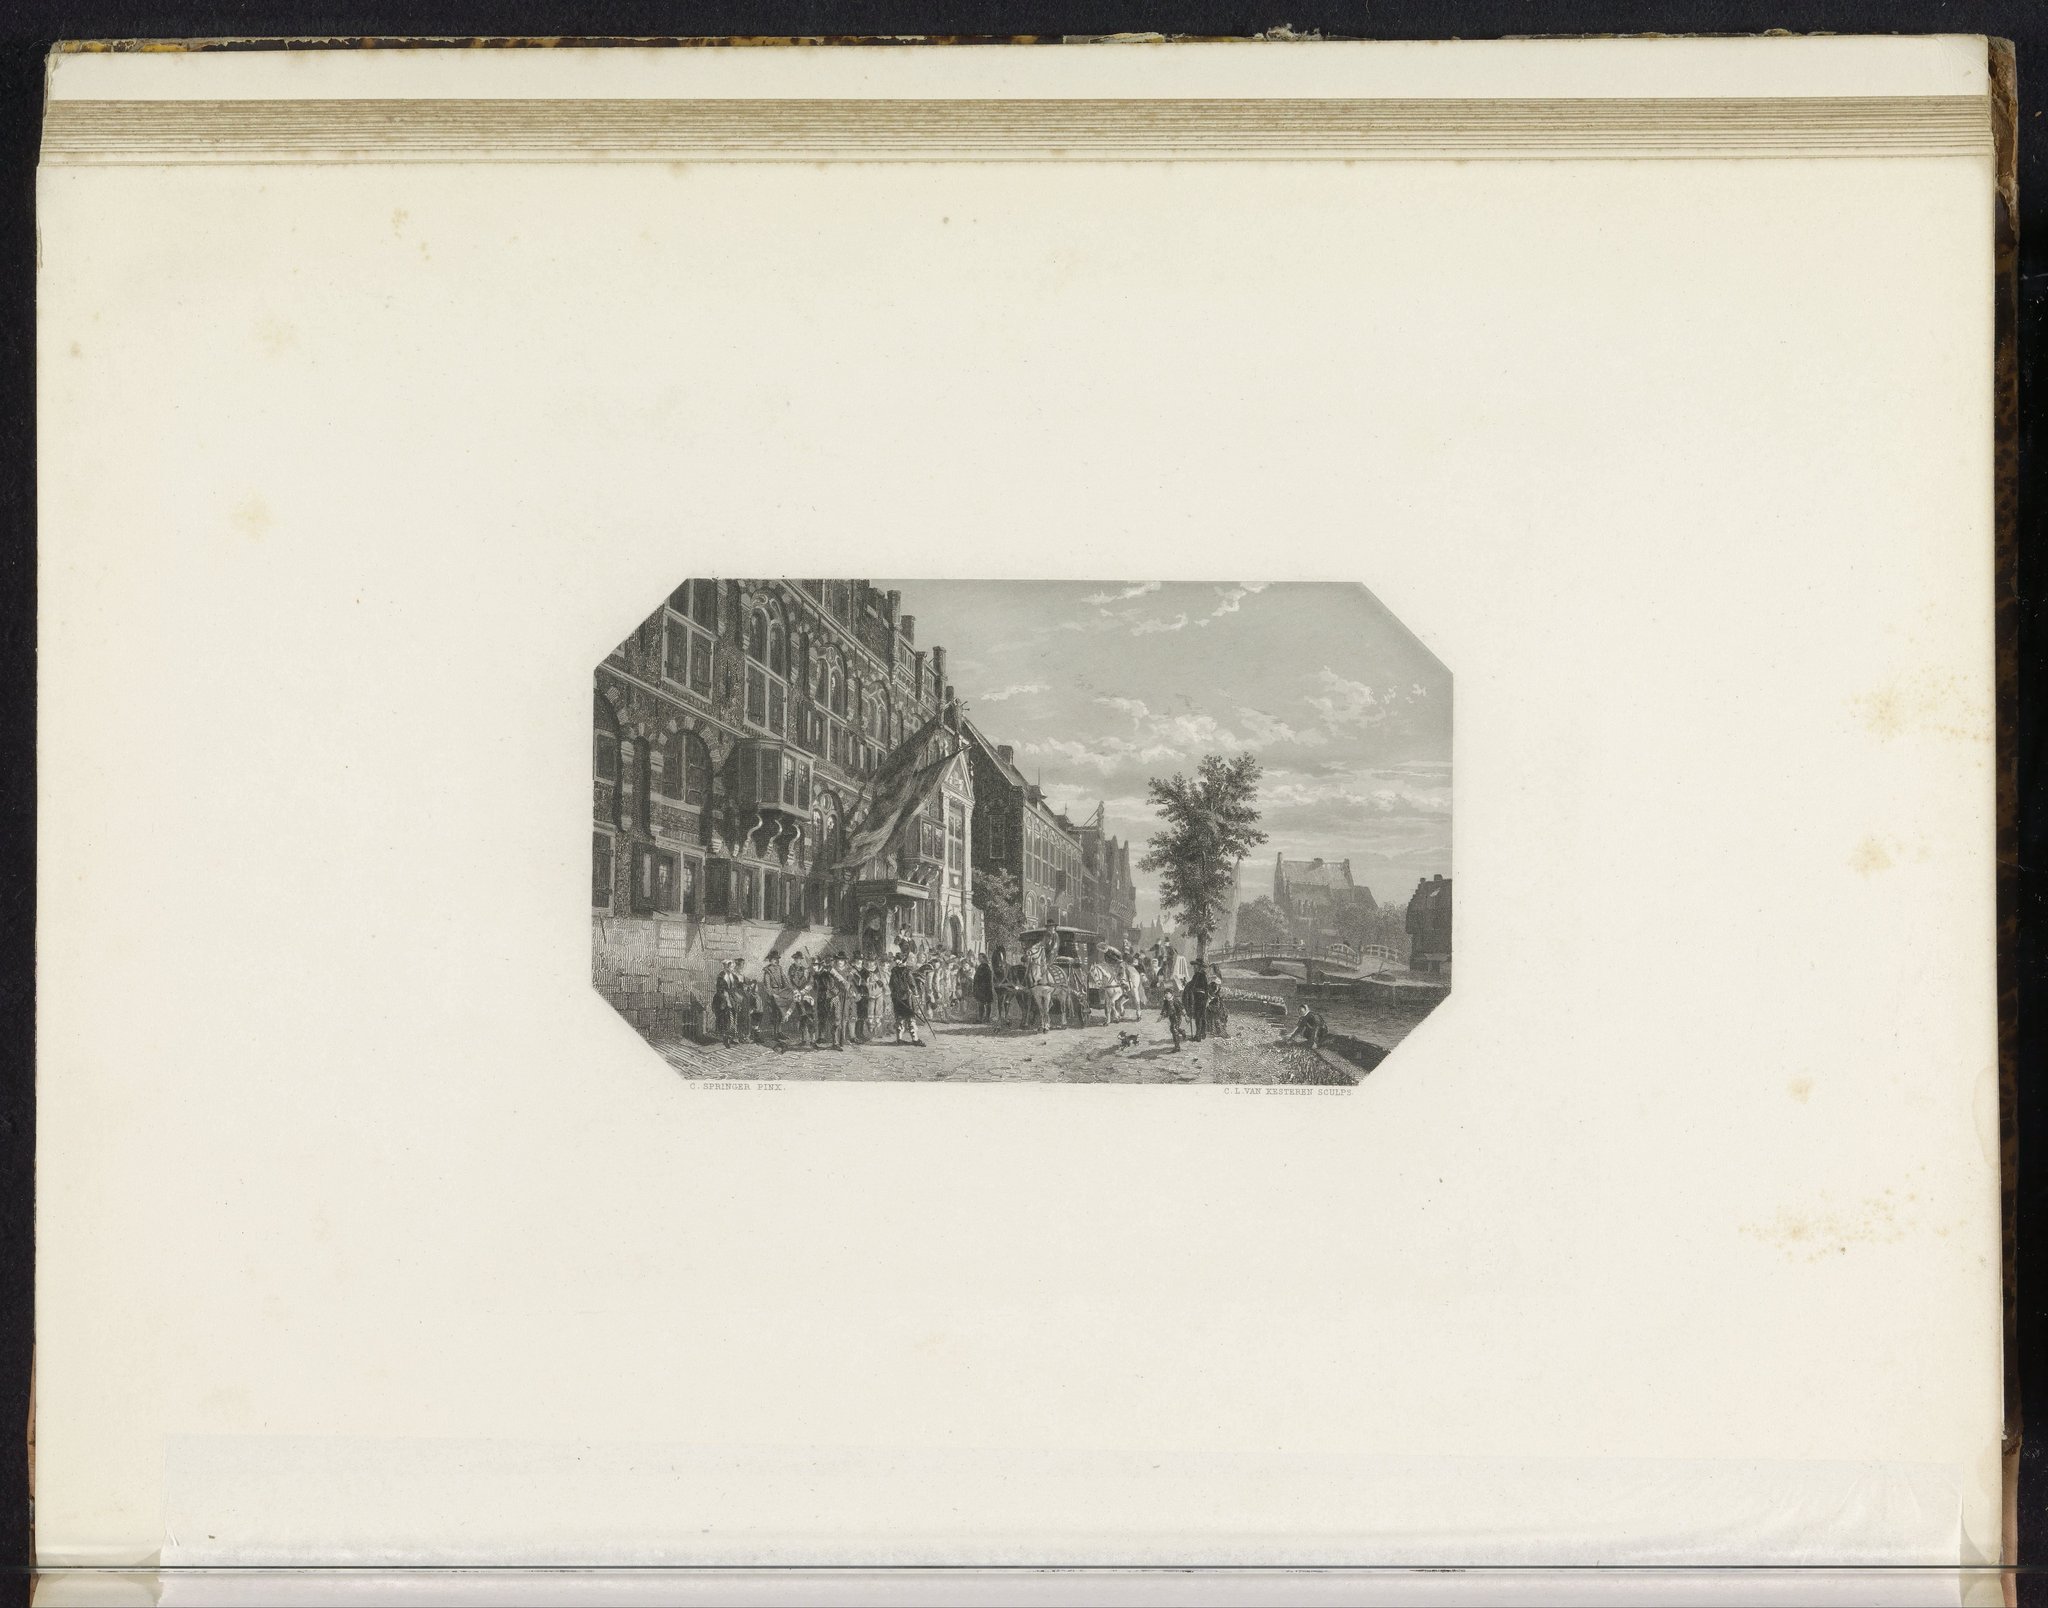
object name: print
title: Schuttersdoelens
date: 1865-1870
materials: paper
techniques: engraving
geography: netherlands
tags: warfare; military affairs (+ citizen soldiery, civil guard, citizen militia)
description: Twee schuttersdoelen te Amsterdam, de Handboogdoelen en de Voetboogdoelen, ca. 1650. Onderdeel van de groep staalgravures naar de schilderijen van de Historische Galerij der Maatschappij Arti et Amicitiae.